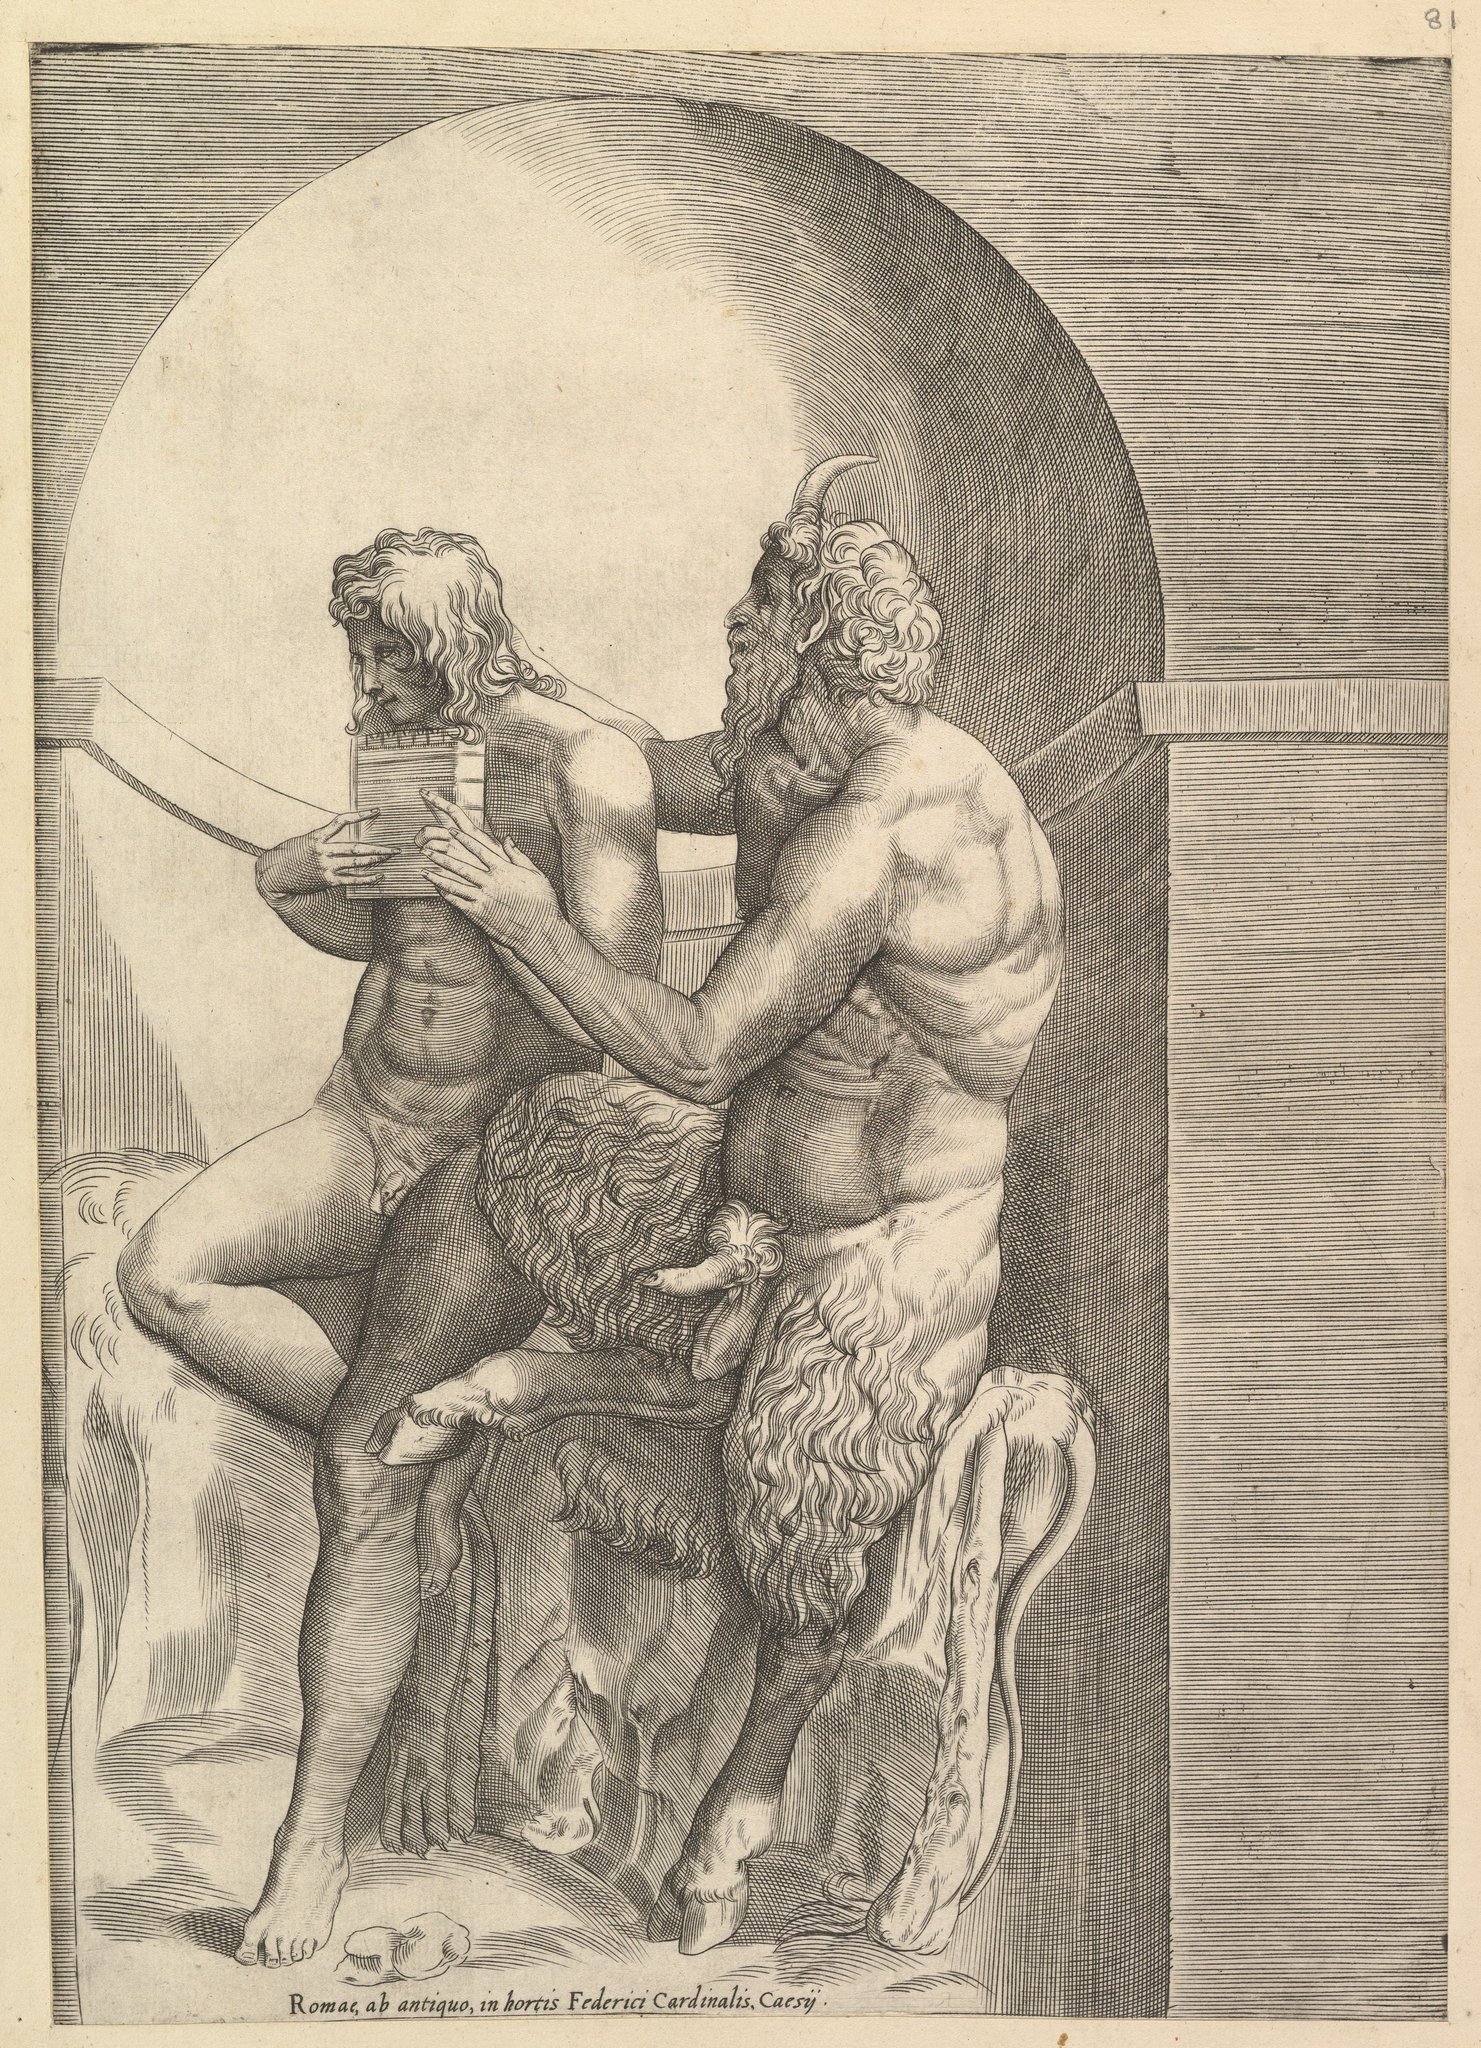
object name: print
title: Pan Teaching the Young Olympus to Play the Flute, from "Speculum Romanae Magnificentiae"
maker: Anonymous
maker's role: artist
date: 1540-1580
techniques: engraving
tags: male nudes,flutes,satyrs,pan